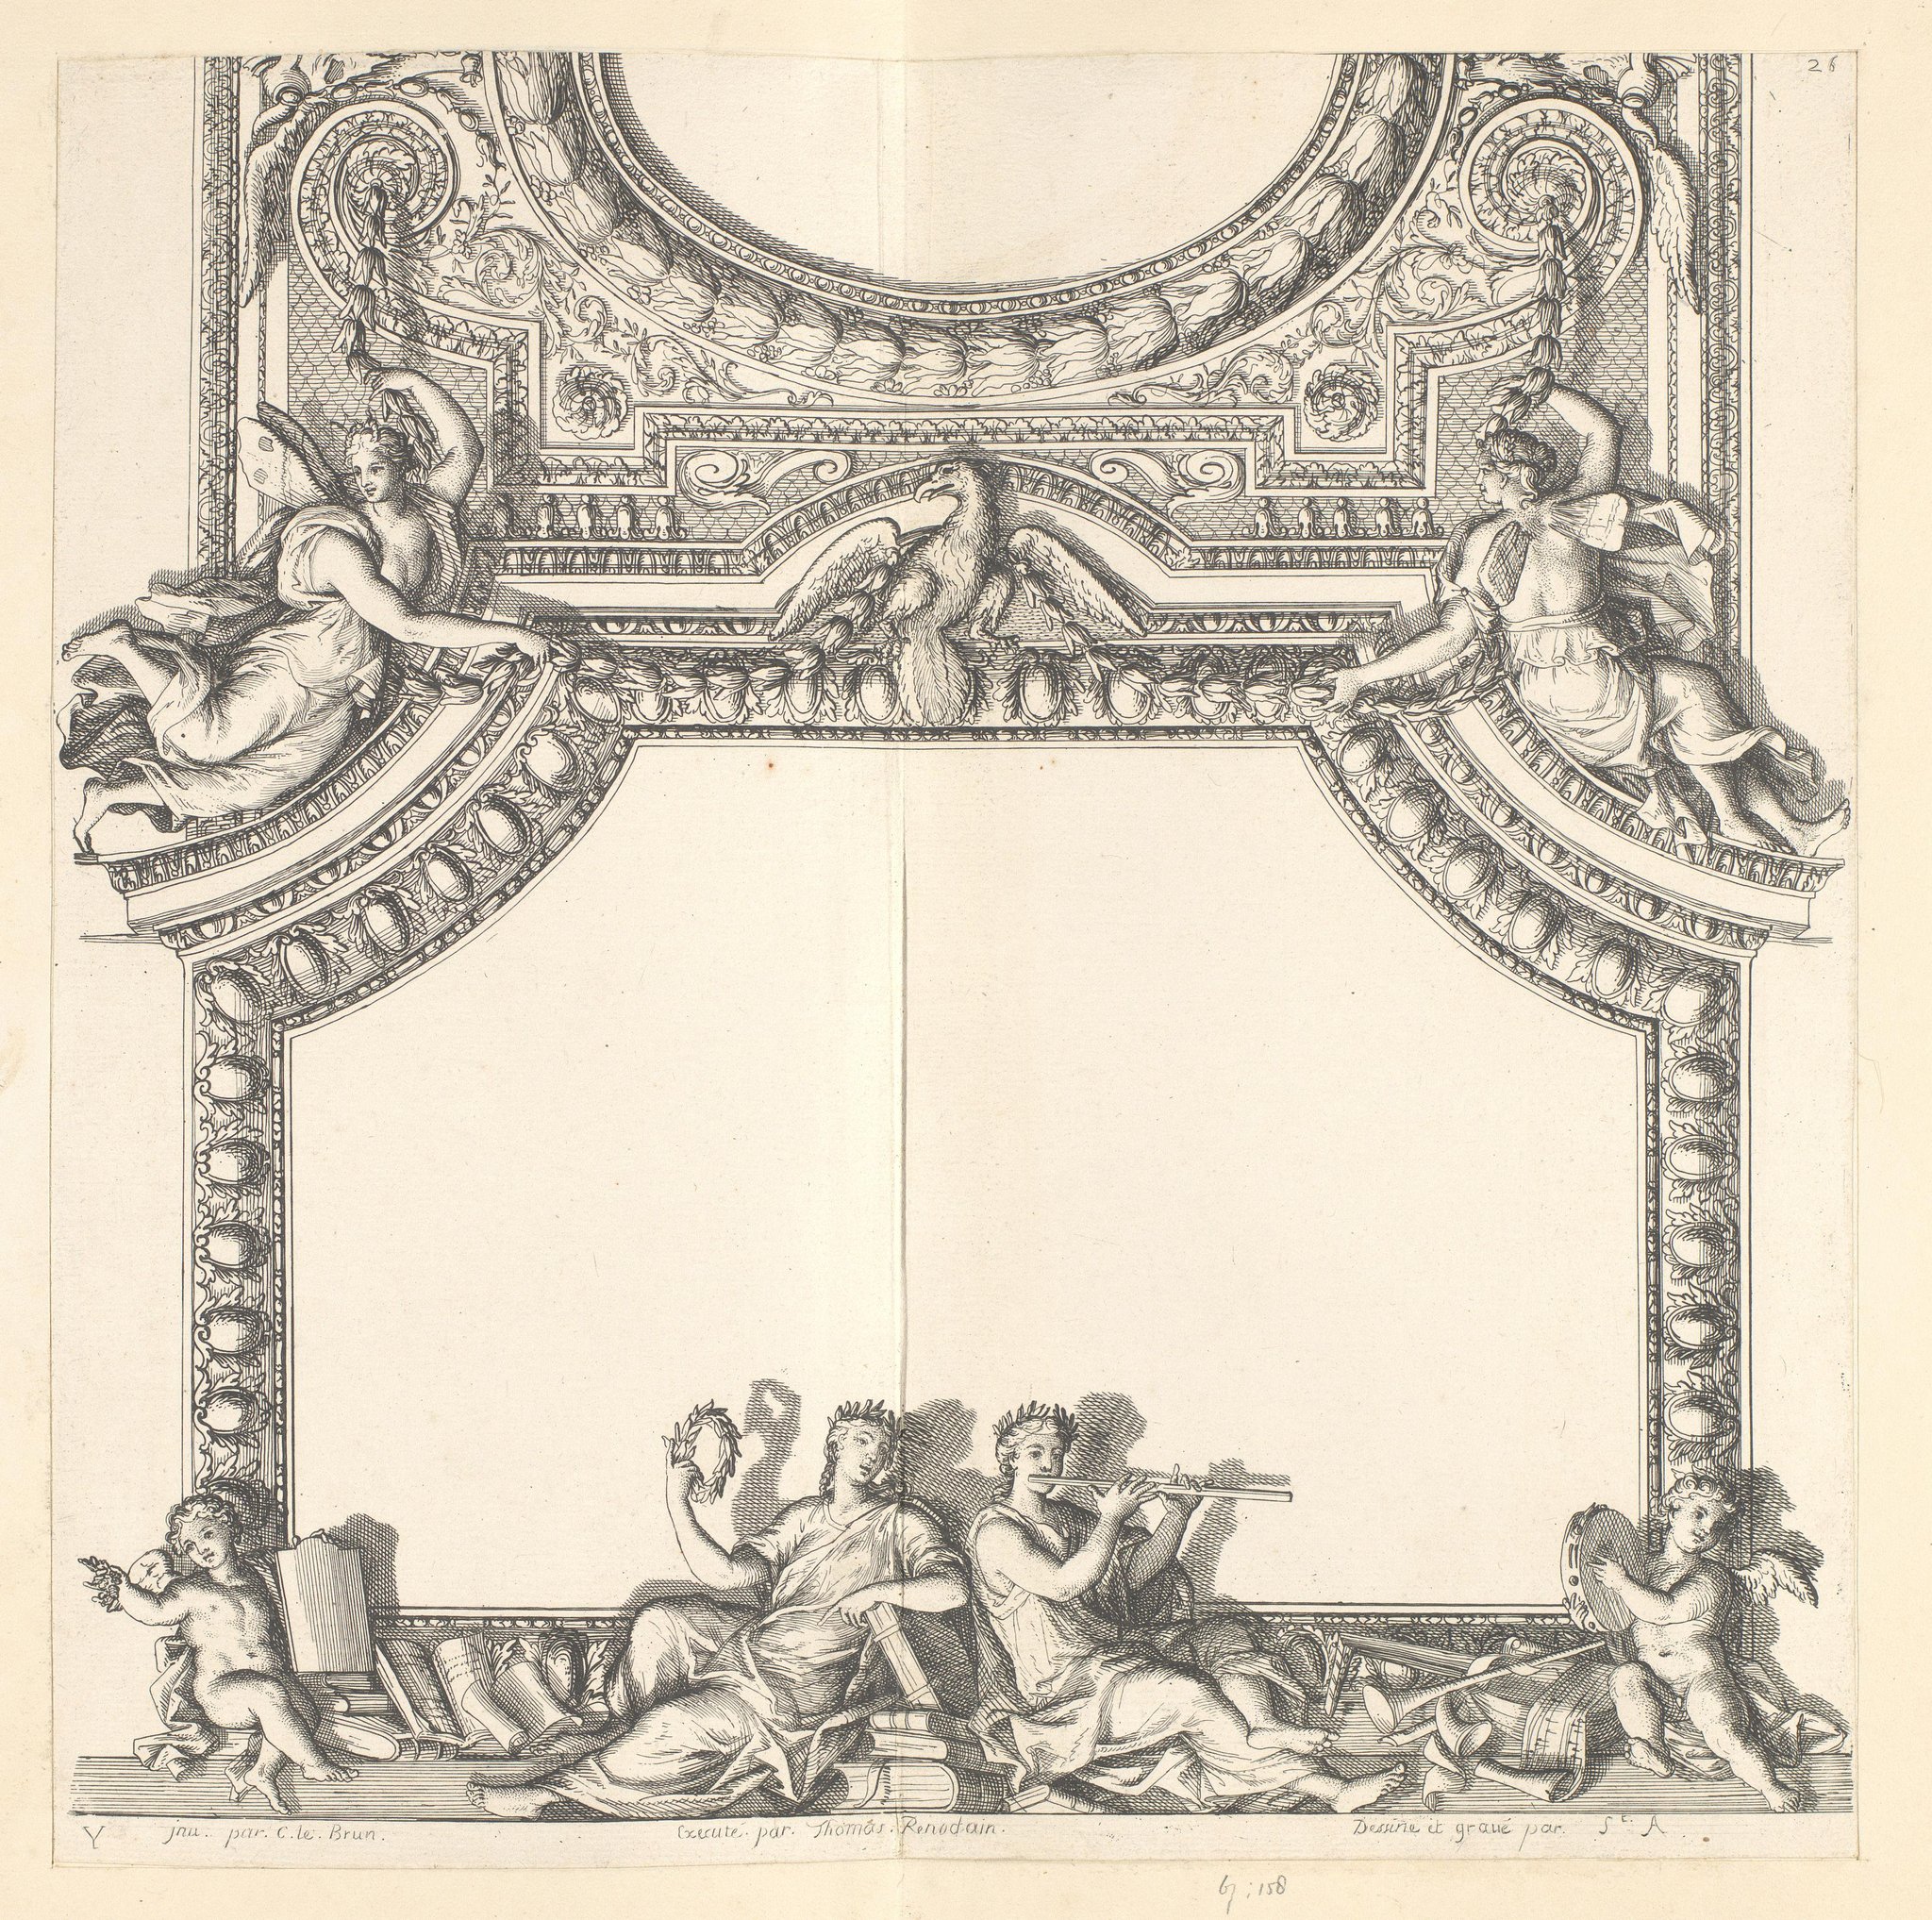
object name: album leaf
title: Ontwerp van een plafond in het Louvre met als thema muziek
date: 1695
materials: paper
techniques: etching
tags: ornaments ~ art, 'musica', symbolic representations, allegories and emblems ~ music; 'musica'(ripa), transverse flute, tambourine, (decorated) ceiling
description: Onder andere een dwarsfluit spelende figuur, en een putto die op een tamboerijn slaat. Deze prent maakt deel uit van een album.